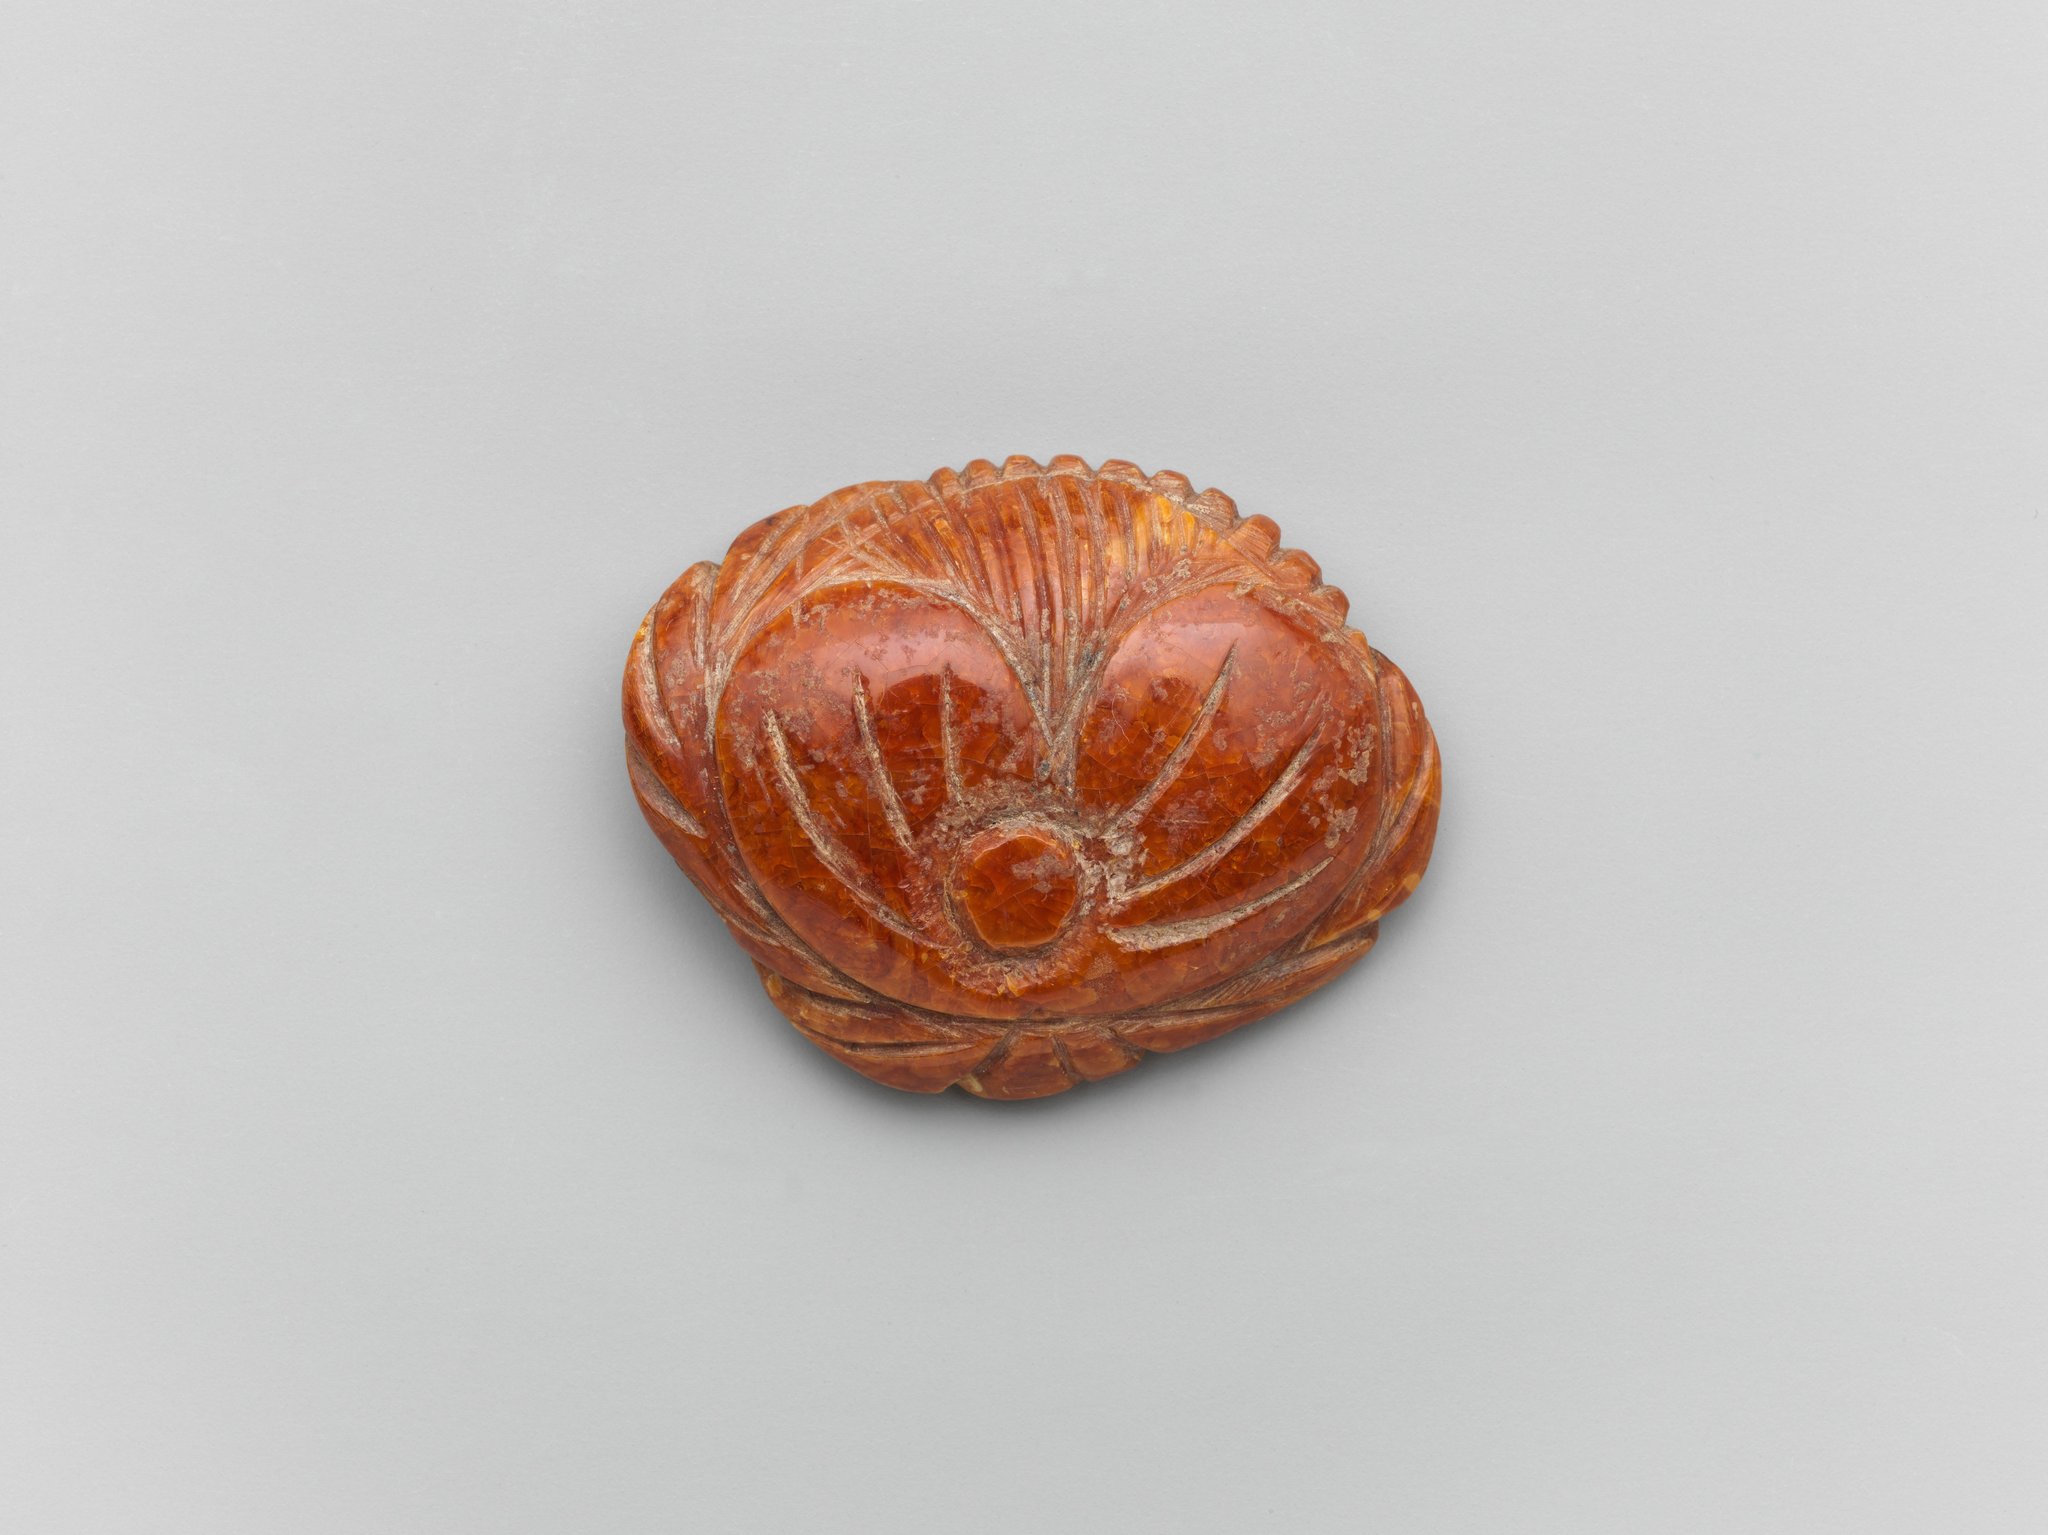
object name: ornament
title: Flower in full blossom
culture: chinese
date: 1001-1100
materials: amber